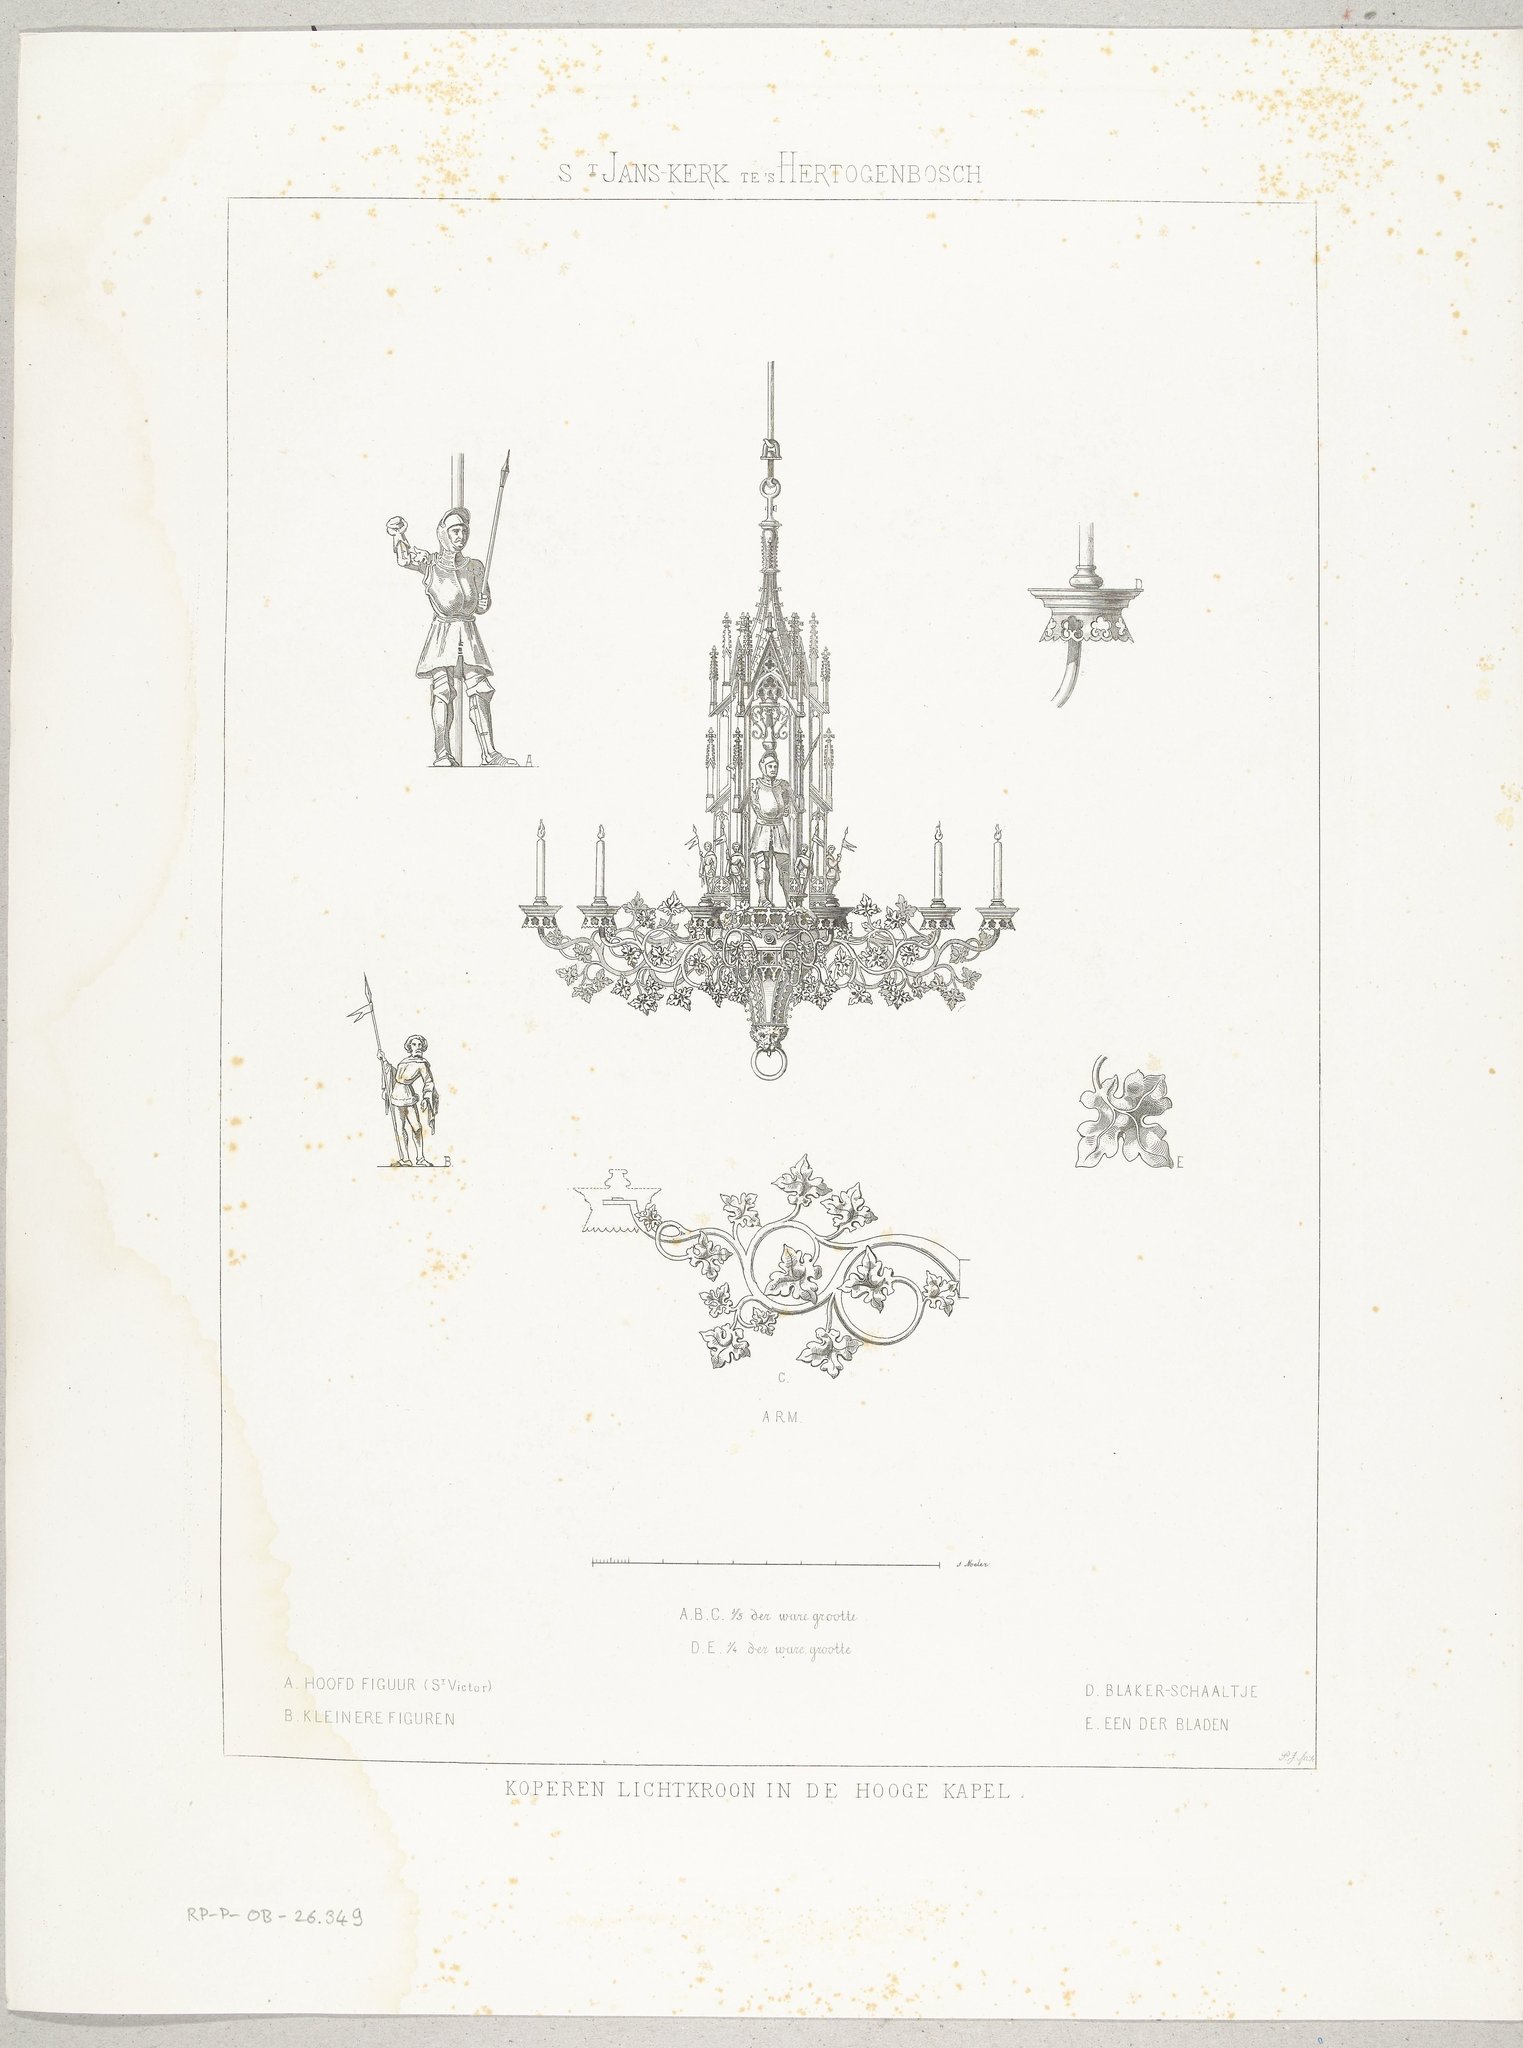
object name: print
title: Kroonluchter uit een kapel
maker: petrus johannes arendzen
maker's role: draughtsman, print maker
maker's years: 1846-1932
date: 1875-1895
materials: paper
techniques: engraving, etching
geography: netherlands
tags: sint-janskathedraal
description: Waarschijnlijk afkomstig uit: J.C.A. Hezenmans, De St. Jans-kerk te 's-Hertogenbosch, uitg. door het Provinciaal Genootschap voor Kunsten en Wetenschappen in Noord-Brabant, 's-Hertogenbosch : Muller, [1895]